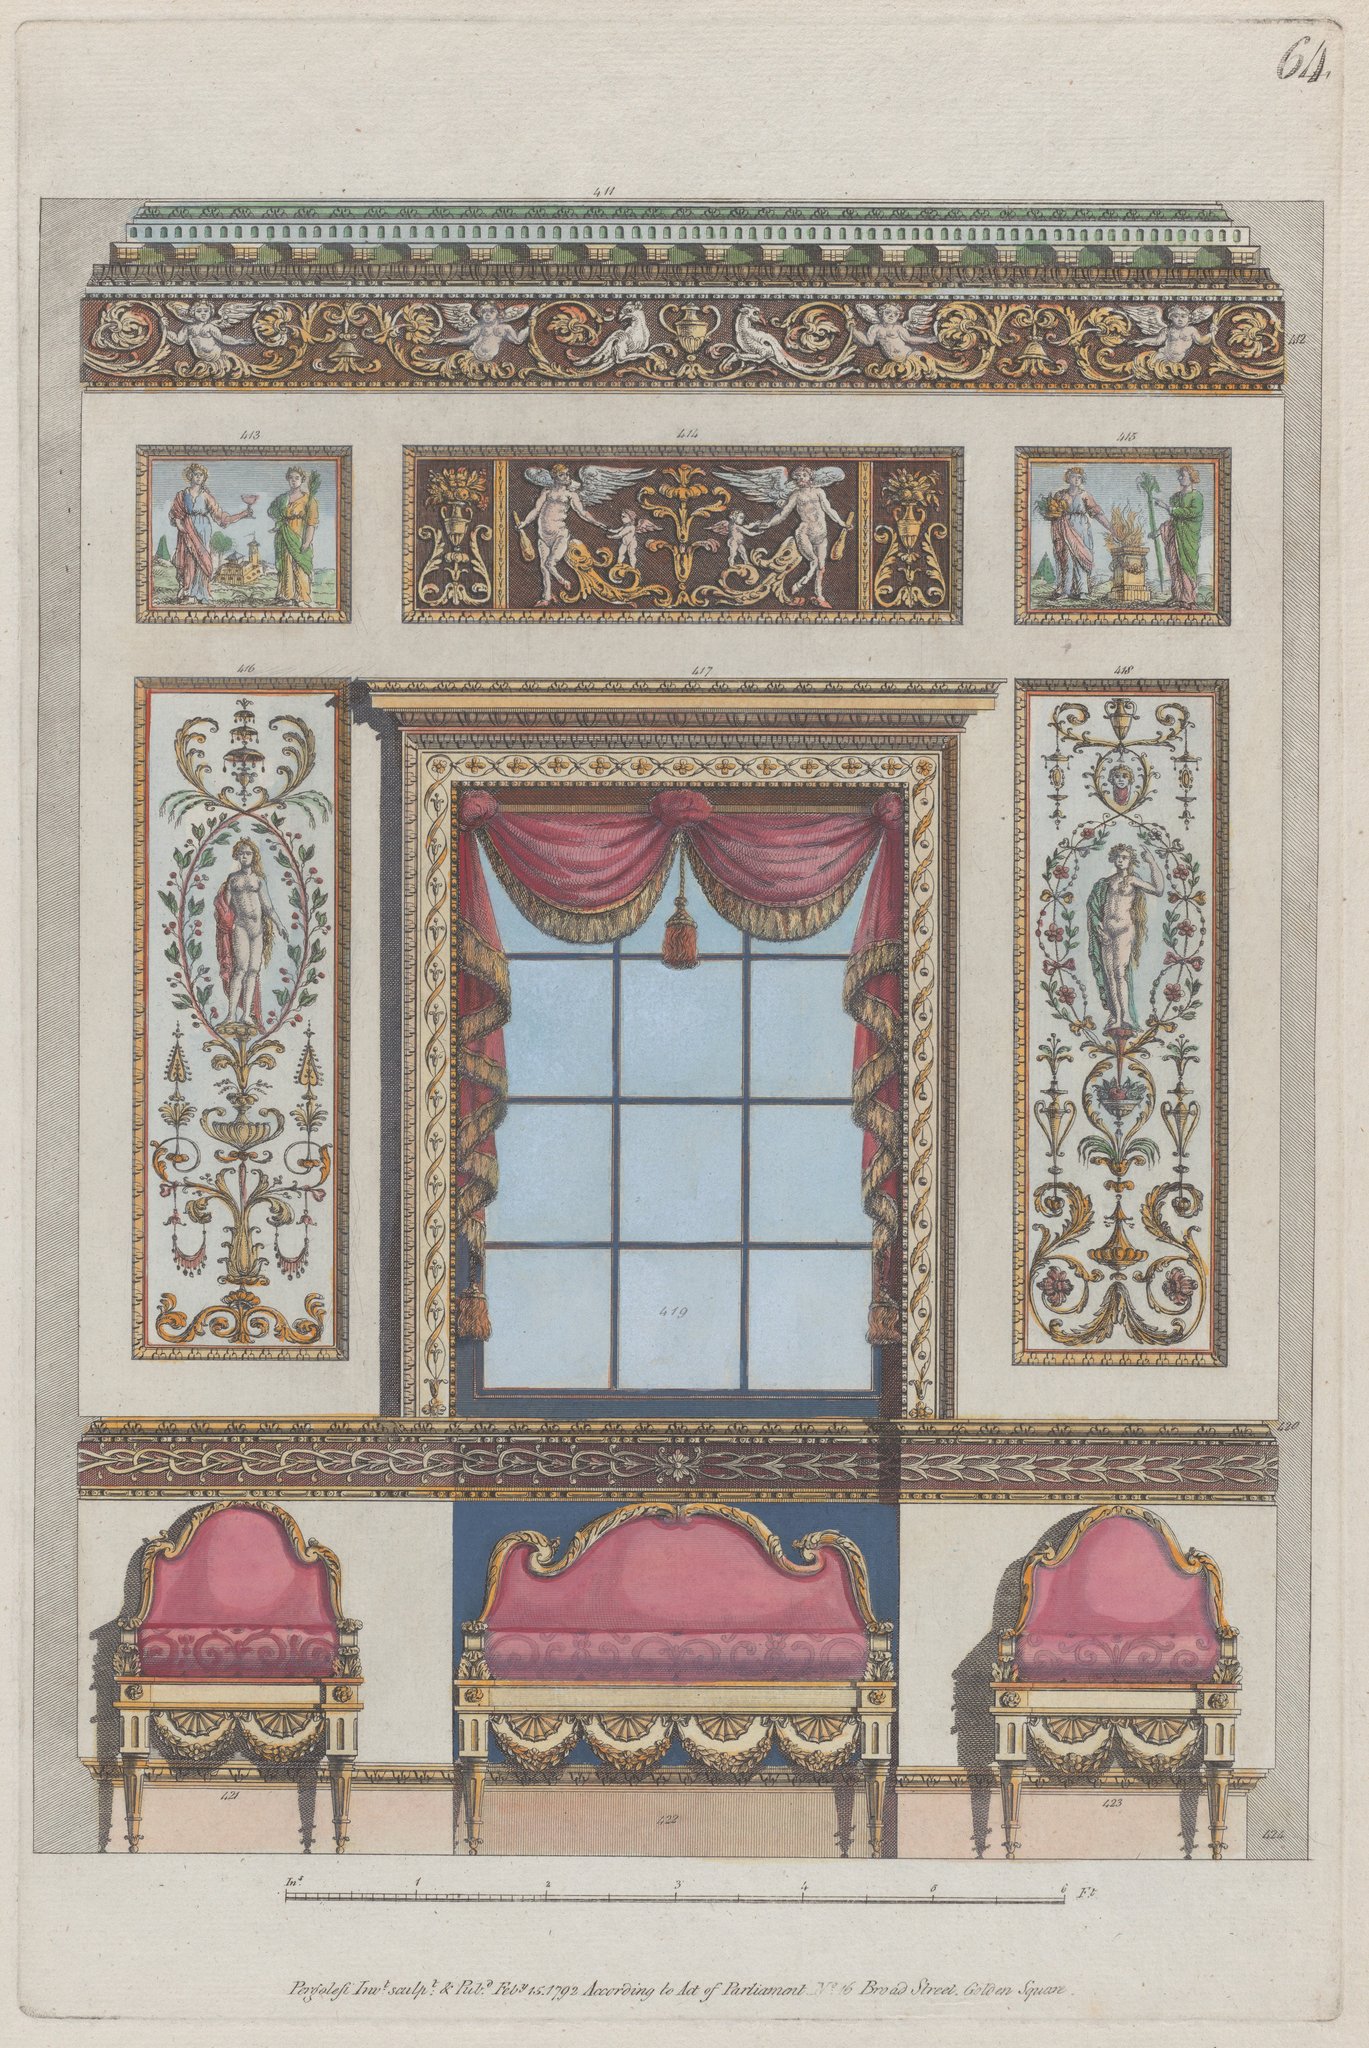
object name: print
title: Interior Ornamented Wall with Window and Furniture, nos. 411–424, plate 64 from "Designs for Various Ornaments"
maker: michelangelo pergolesi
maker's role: artist and publisher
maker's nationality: italian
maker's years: 1760-1801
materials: watercolor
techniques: etching